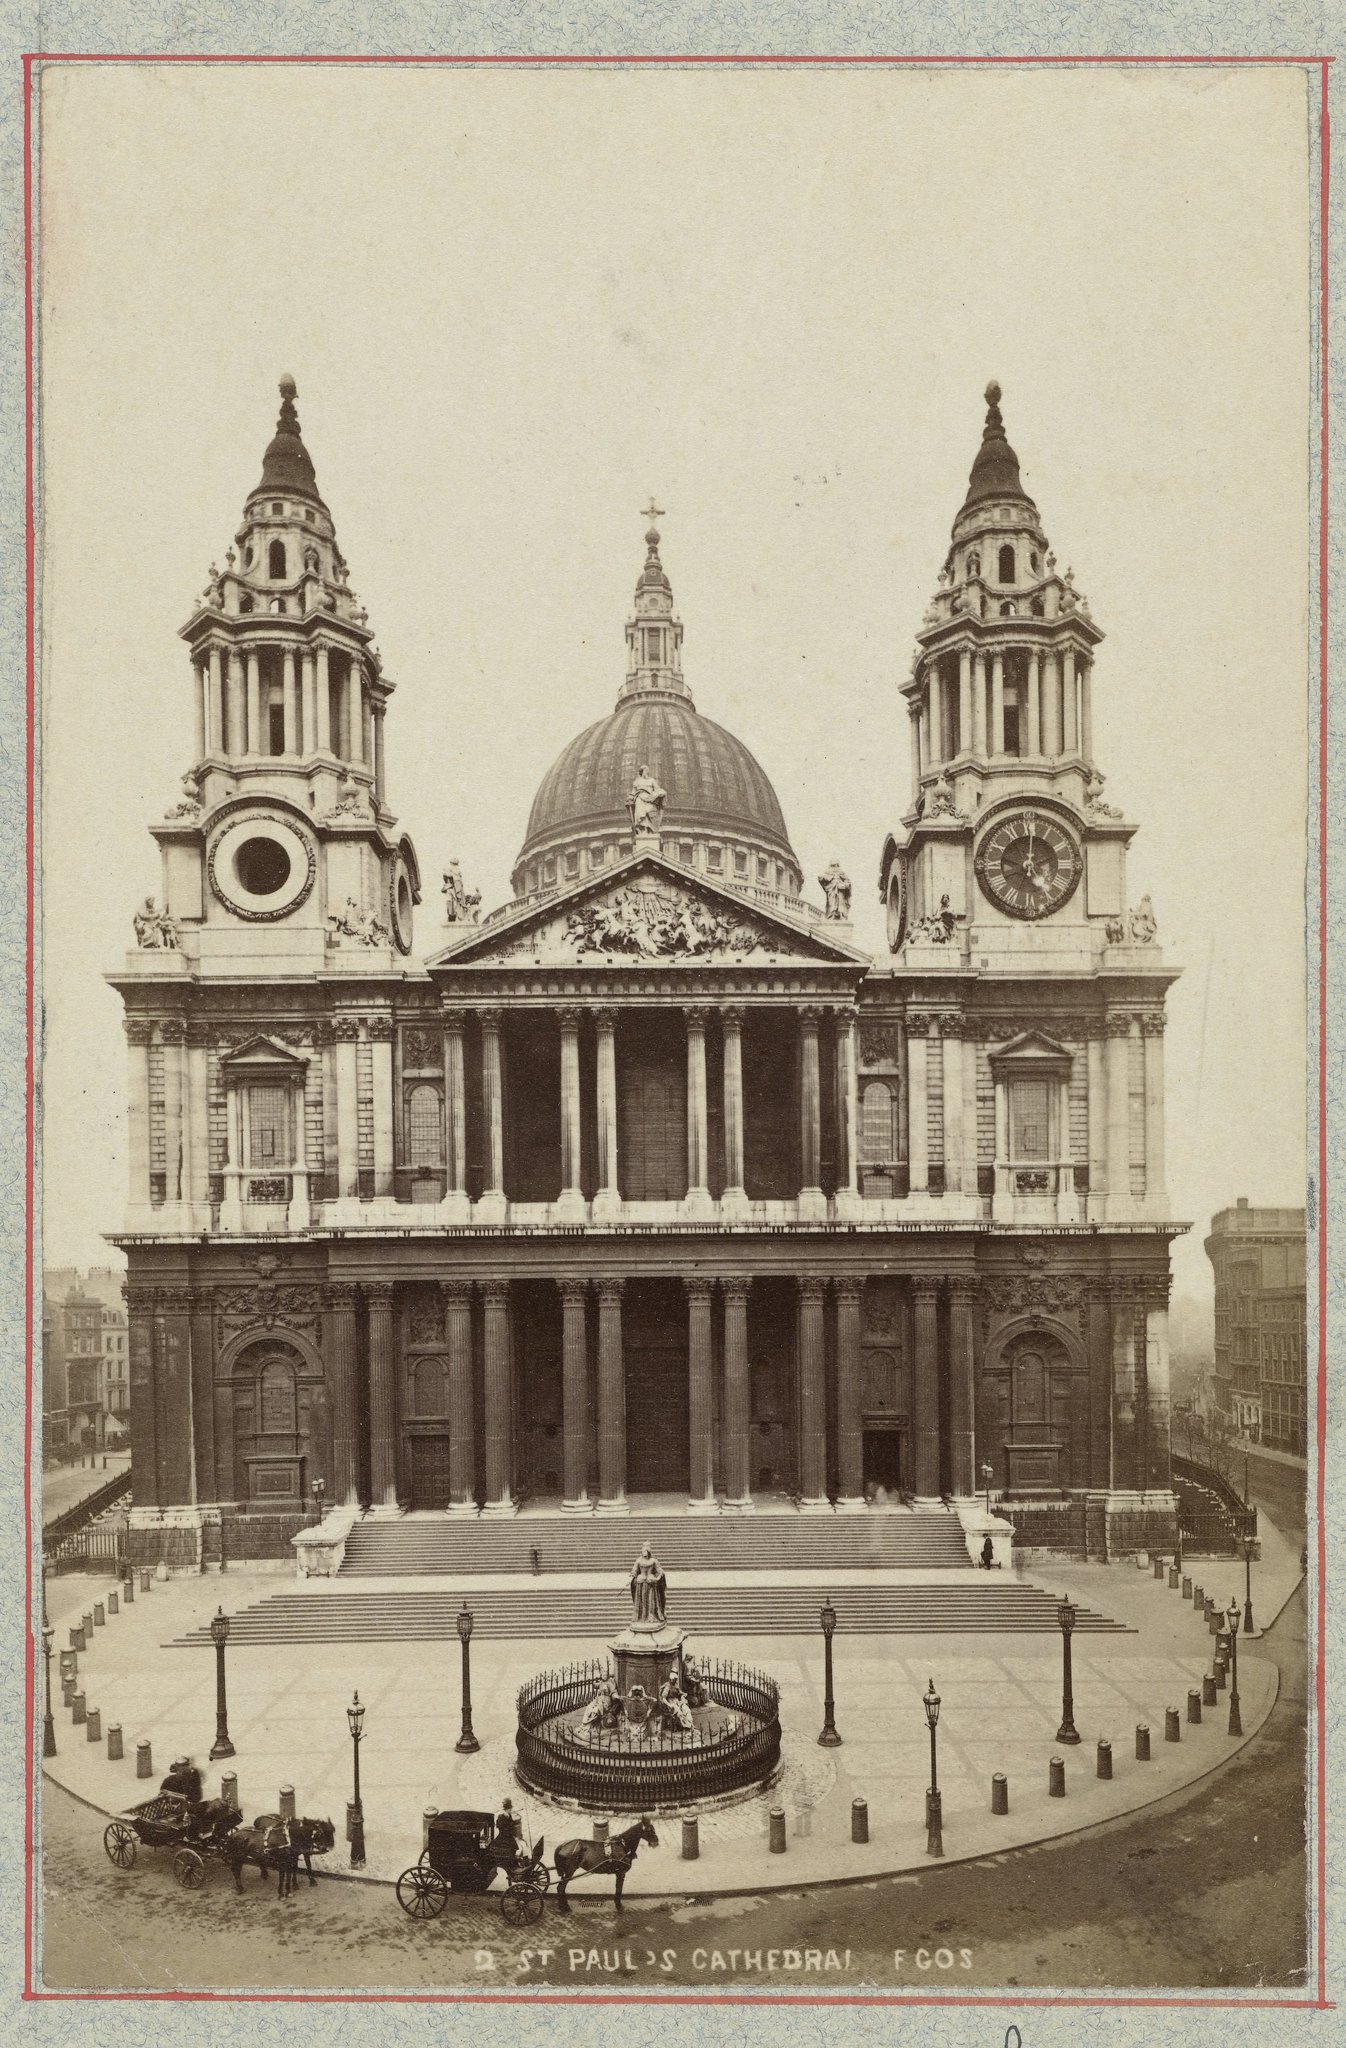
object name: photograph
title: St Paul's Cathedral in Londen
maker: francis godolphin osbourne stuart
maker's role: fotograaf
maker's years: 1843-1923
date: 1870-1881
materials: cardboard, paper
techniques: albumen print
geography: london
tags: church (exterior)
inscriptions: inscription: ‘2 FGOS’